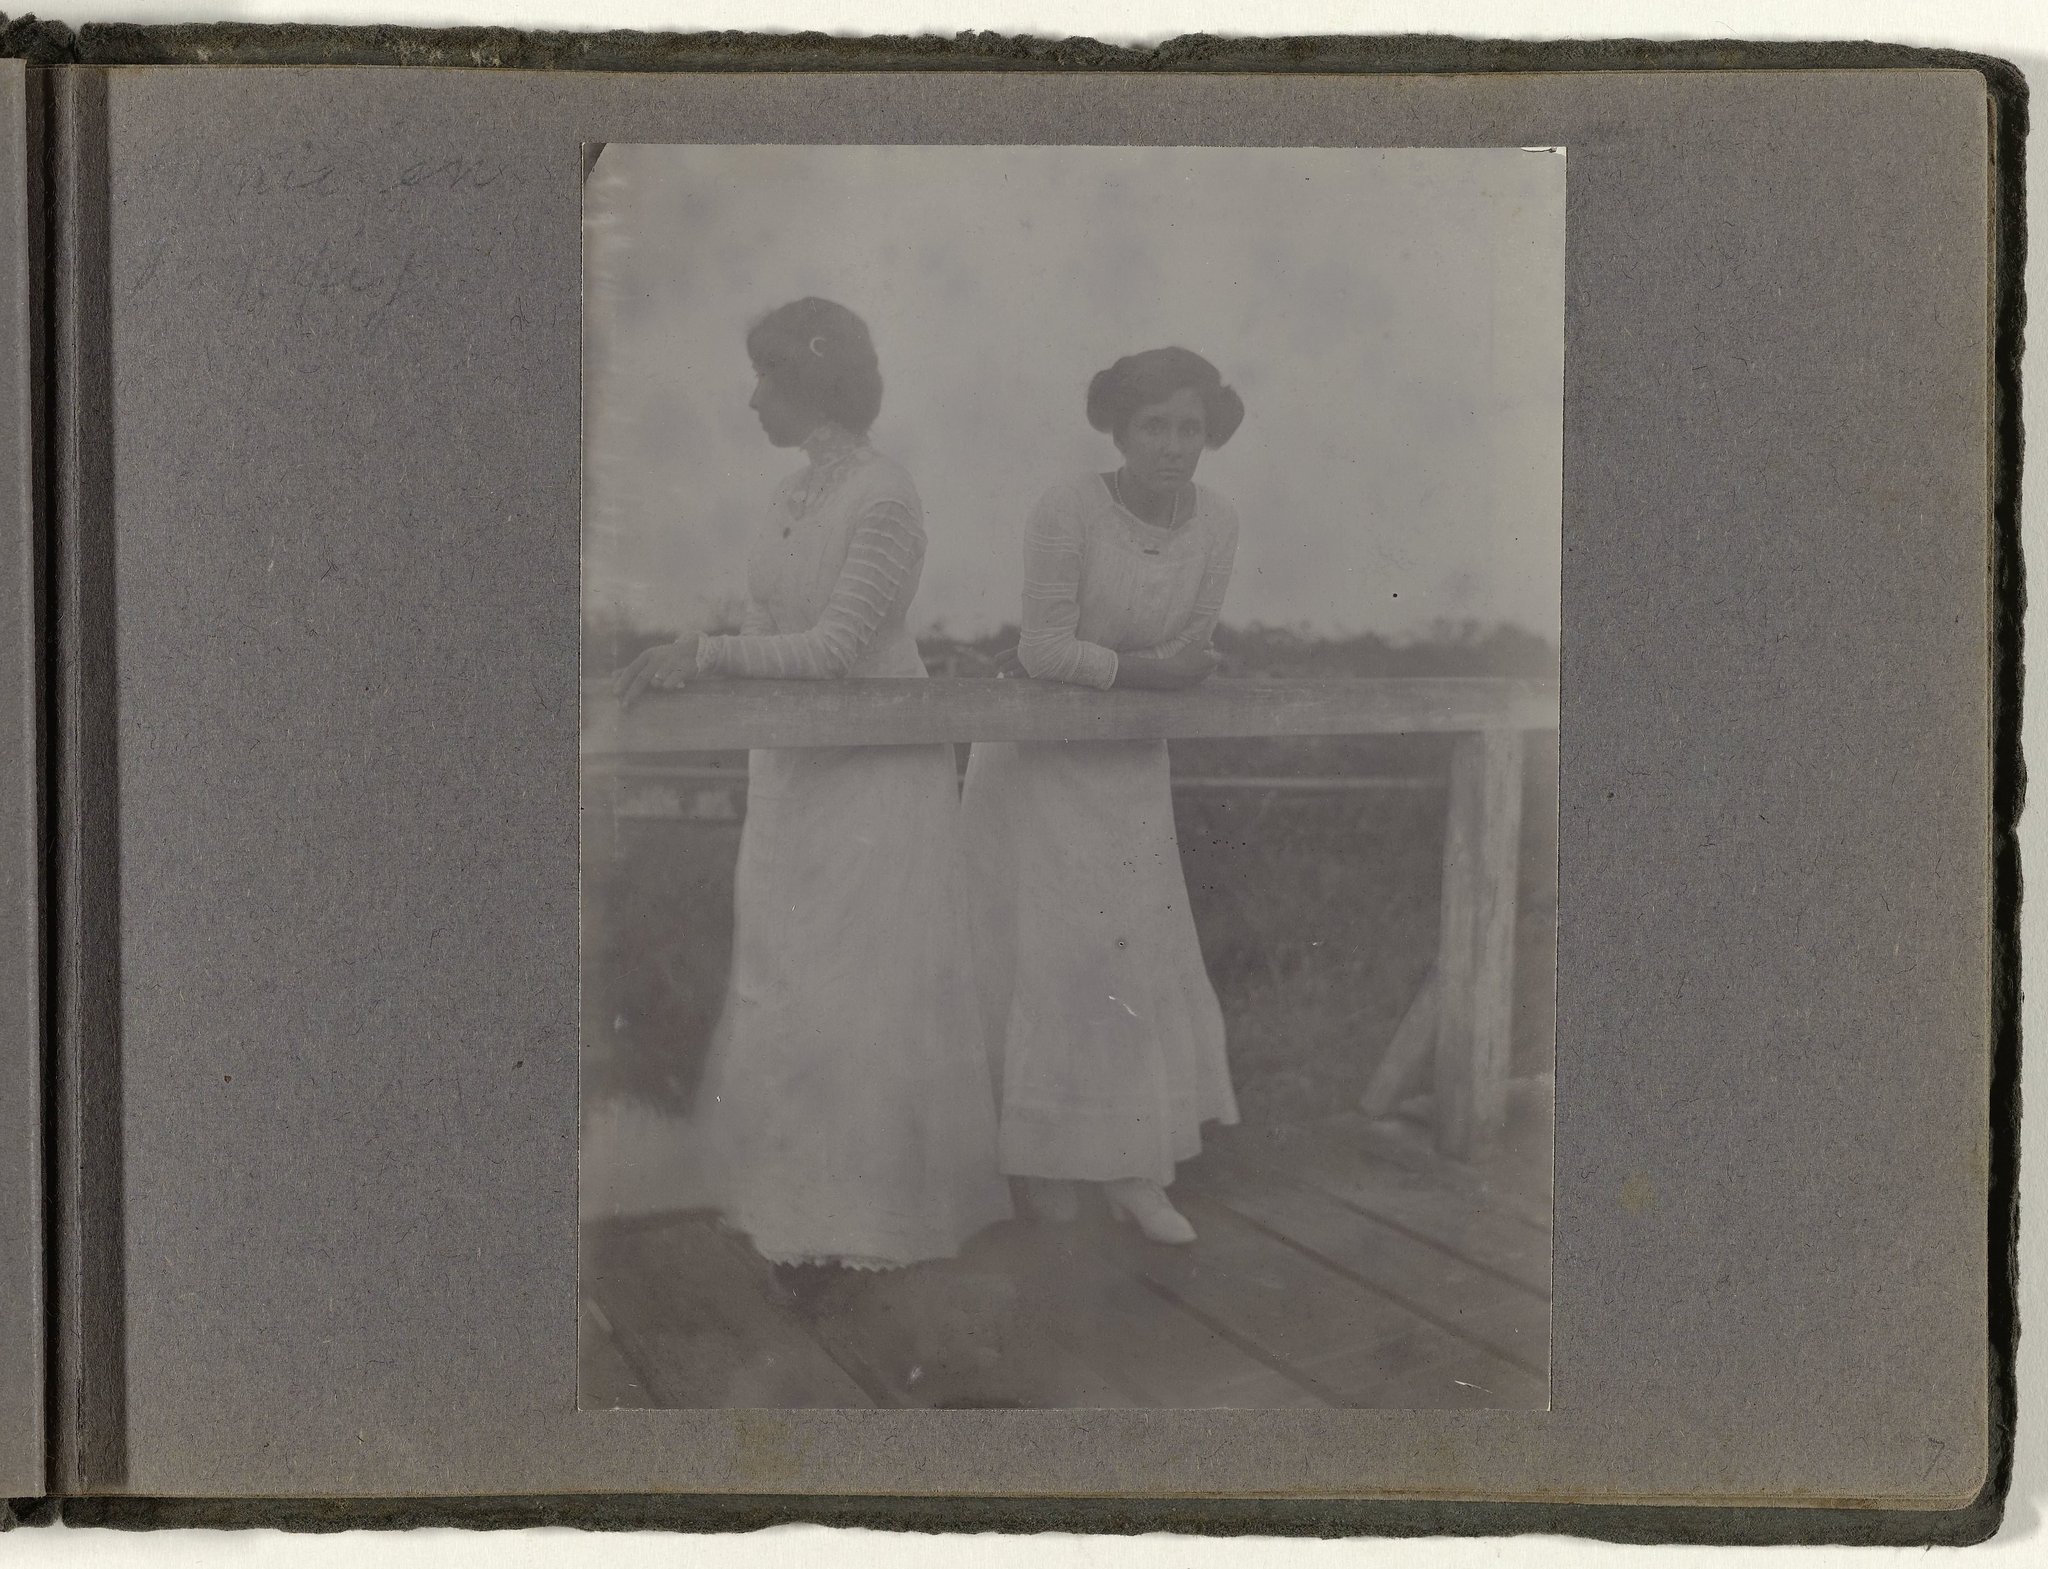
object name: photograph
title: Maria Gonggrijp en een vriendin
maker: Anonymous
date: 1910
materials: photographic support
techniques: gelatin silver print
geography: suriname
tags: suriname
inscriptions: inscription: ‘Annie en Poppie’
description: Maria Gonggrijp en een vriendin staande op een houten brug op de plantage Clevia. Onderdeel van het fotoalbum over de familie Gonggrijp op de plantages Clevia en Morgenstond in Suriname rond 1910.